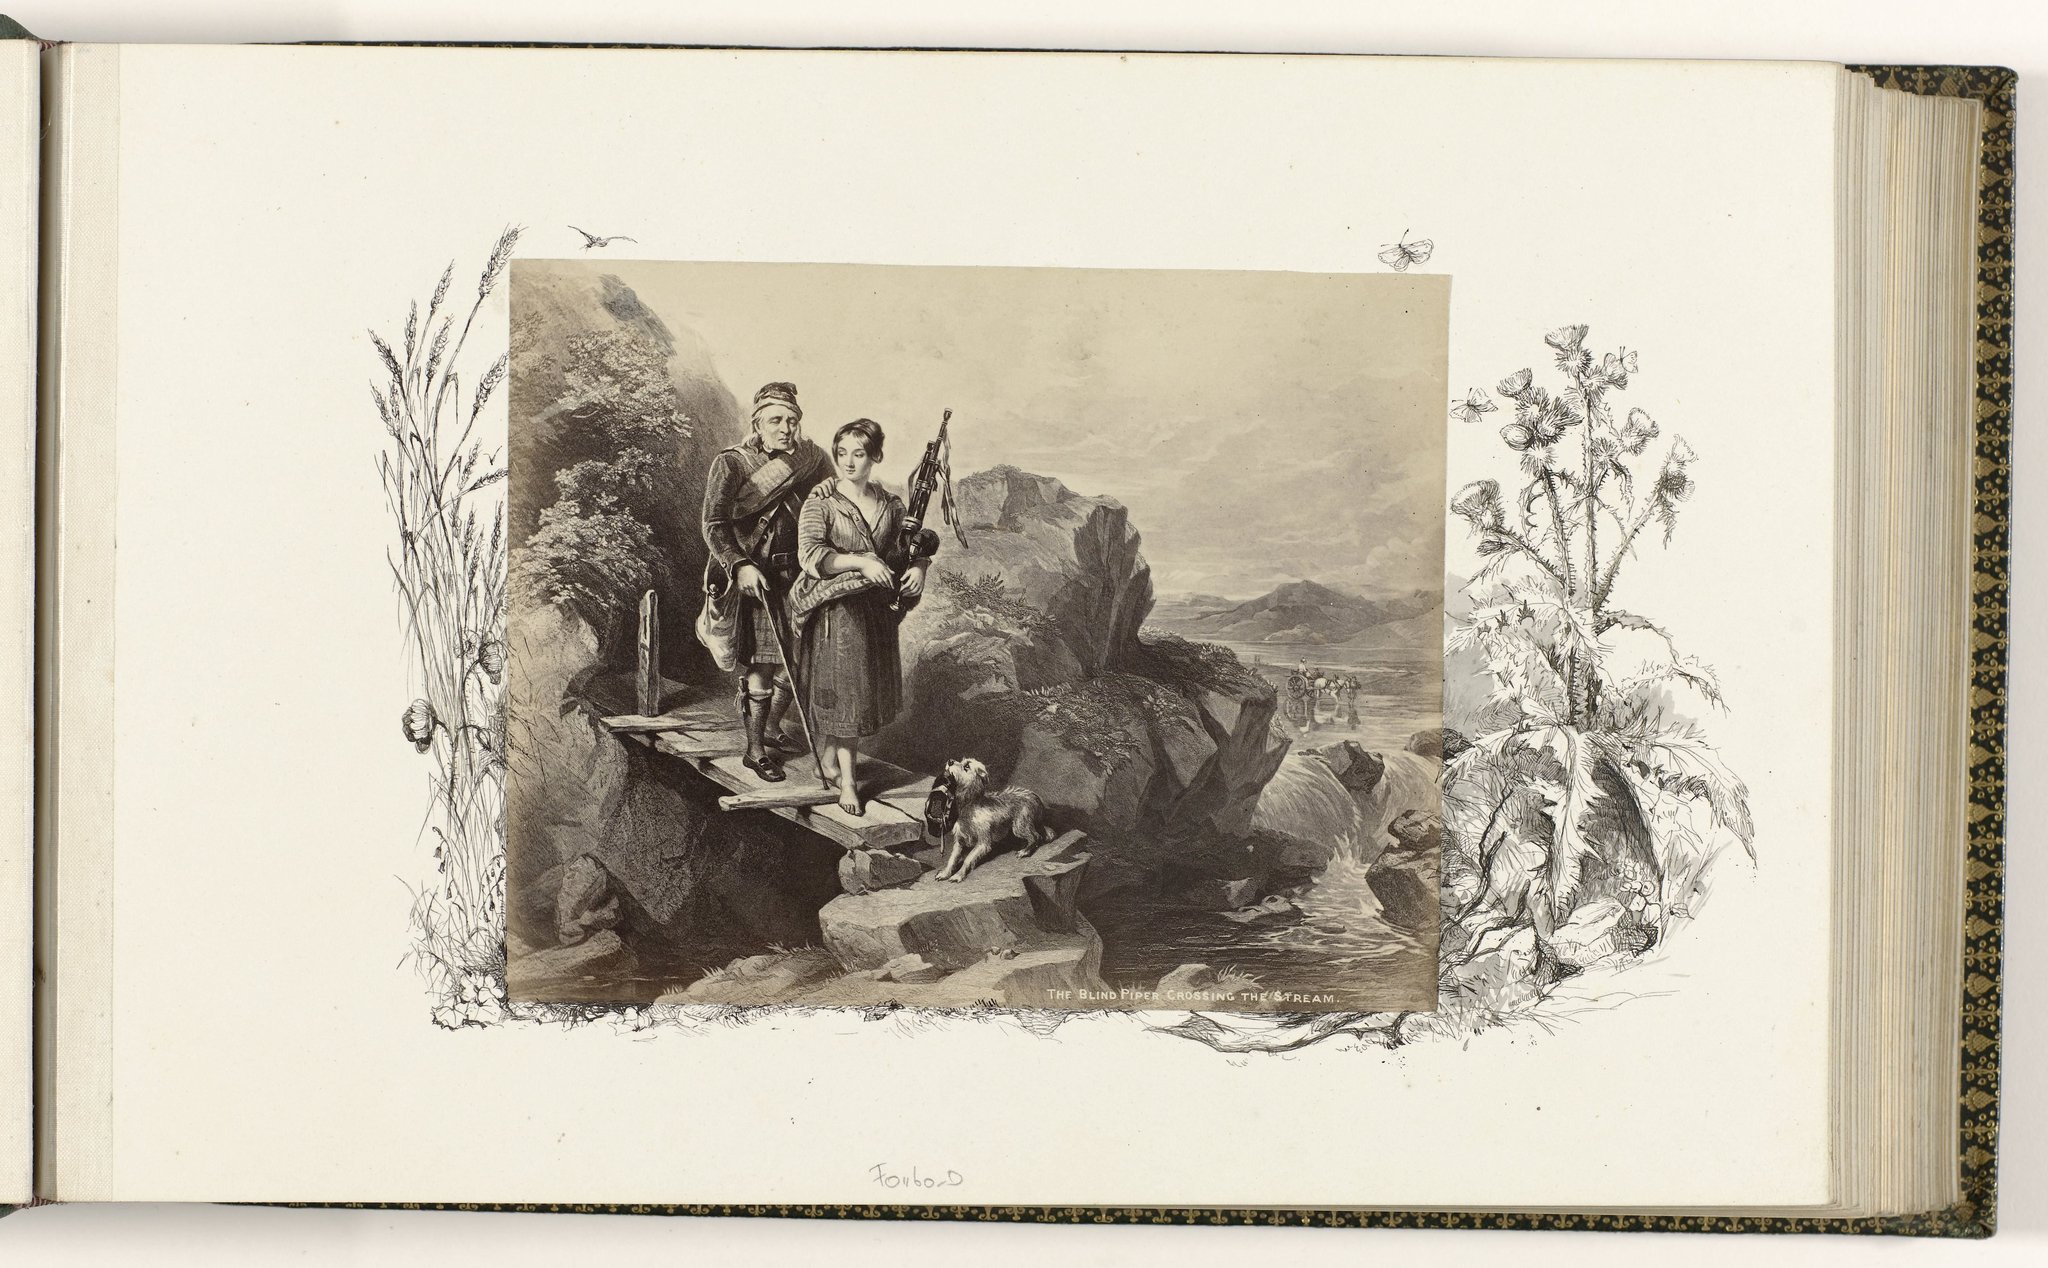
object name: reproduction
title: The blind piper crossing the stream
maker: Anonymous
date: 1870-1875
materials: paper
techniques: albumen print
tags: print, e.g.: engraving, etching, lithograph